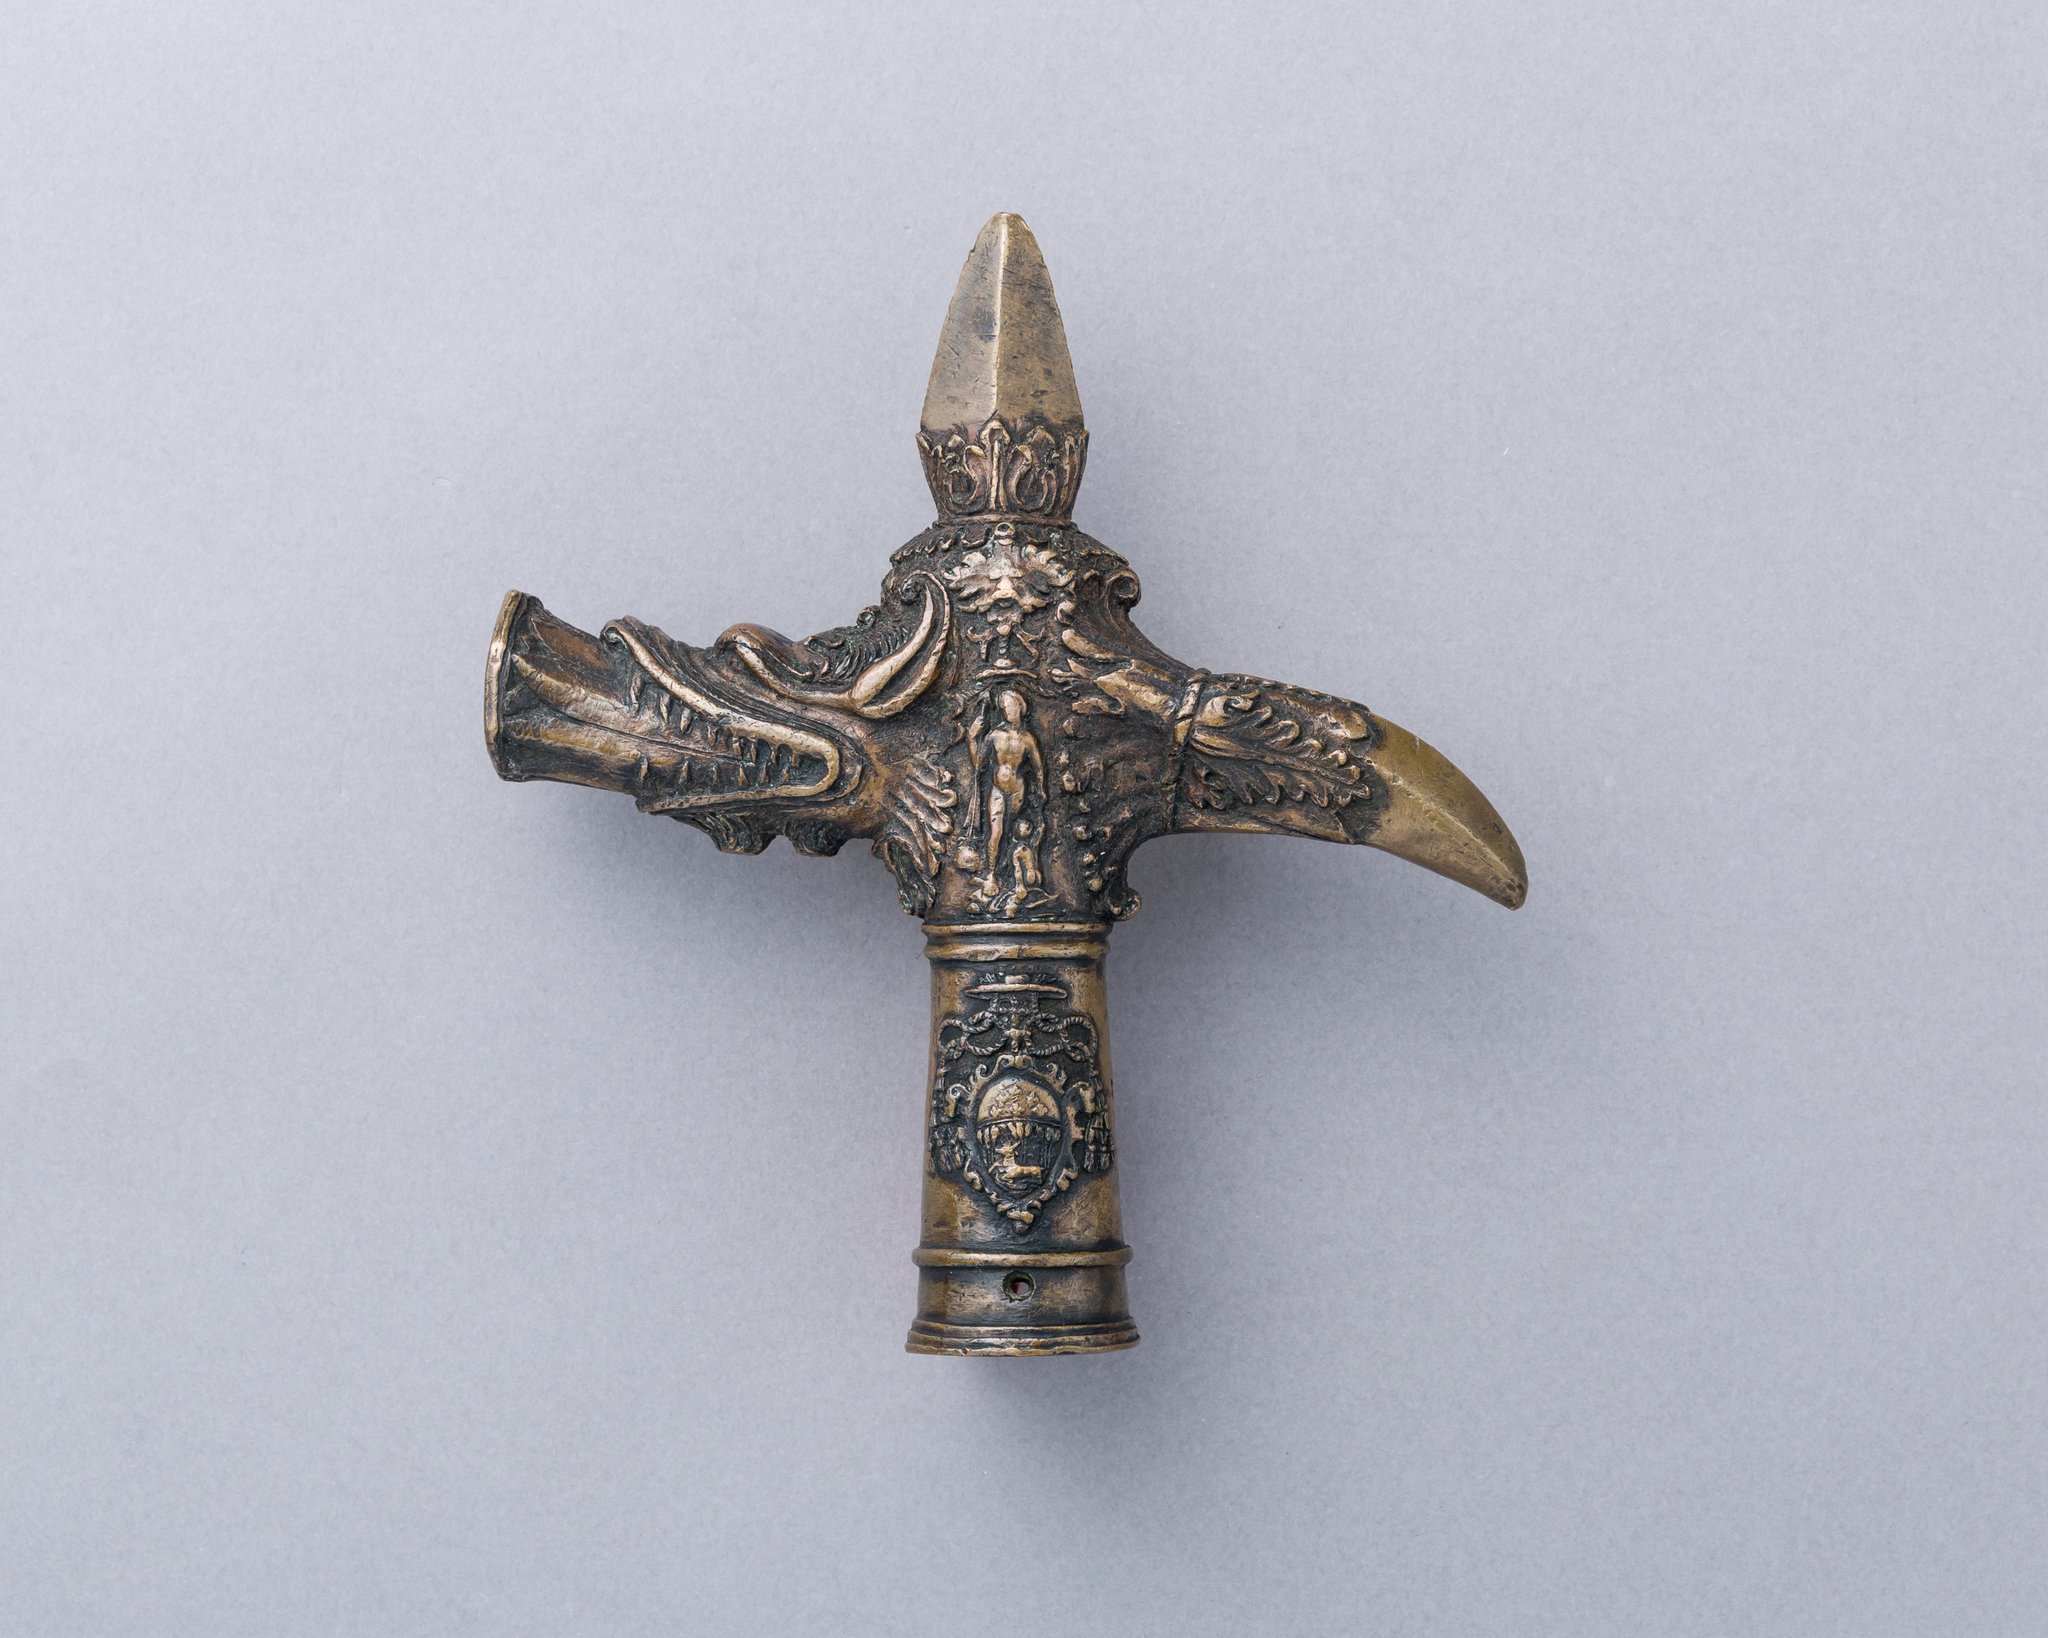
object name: head of a ceremonial war hammer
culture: italian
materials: bronze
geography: italy